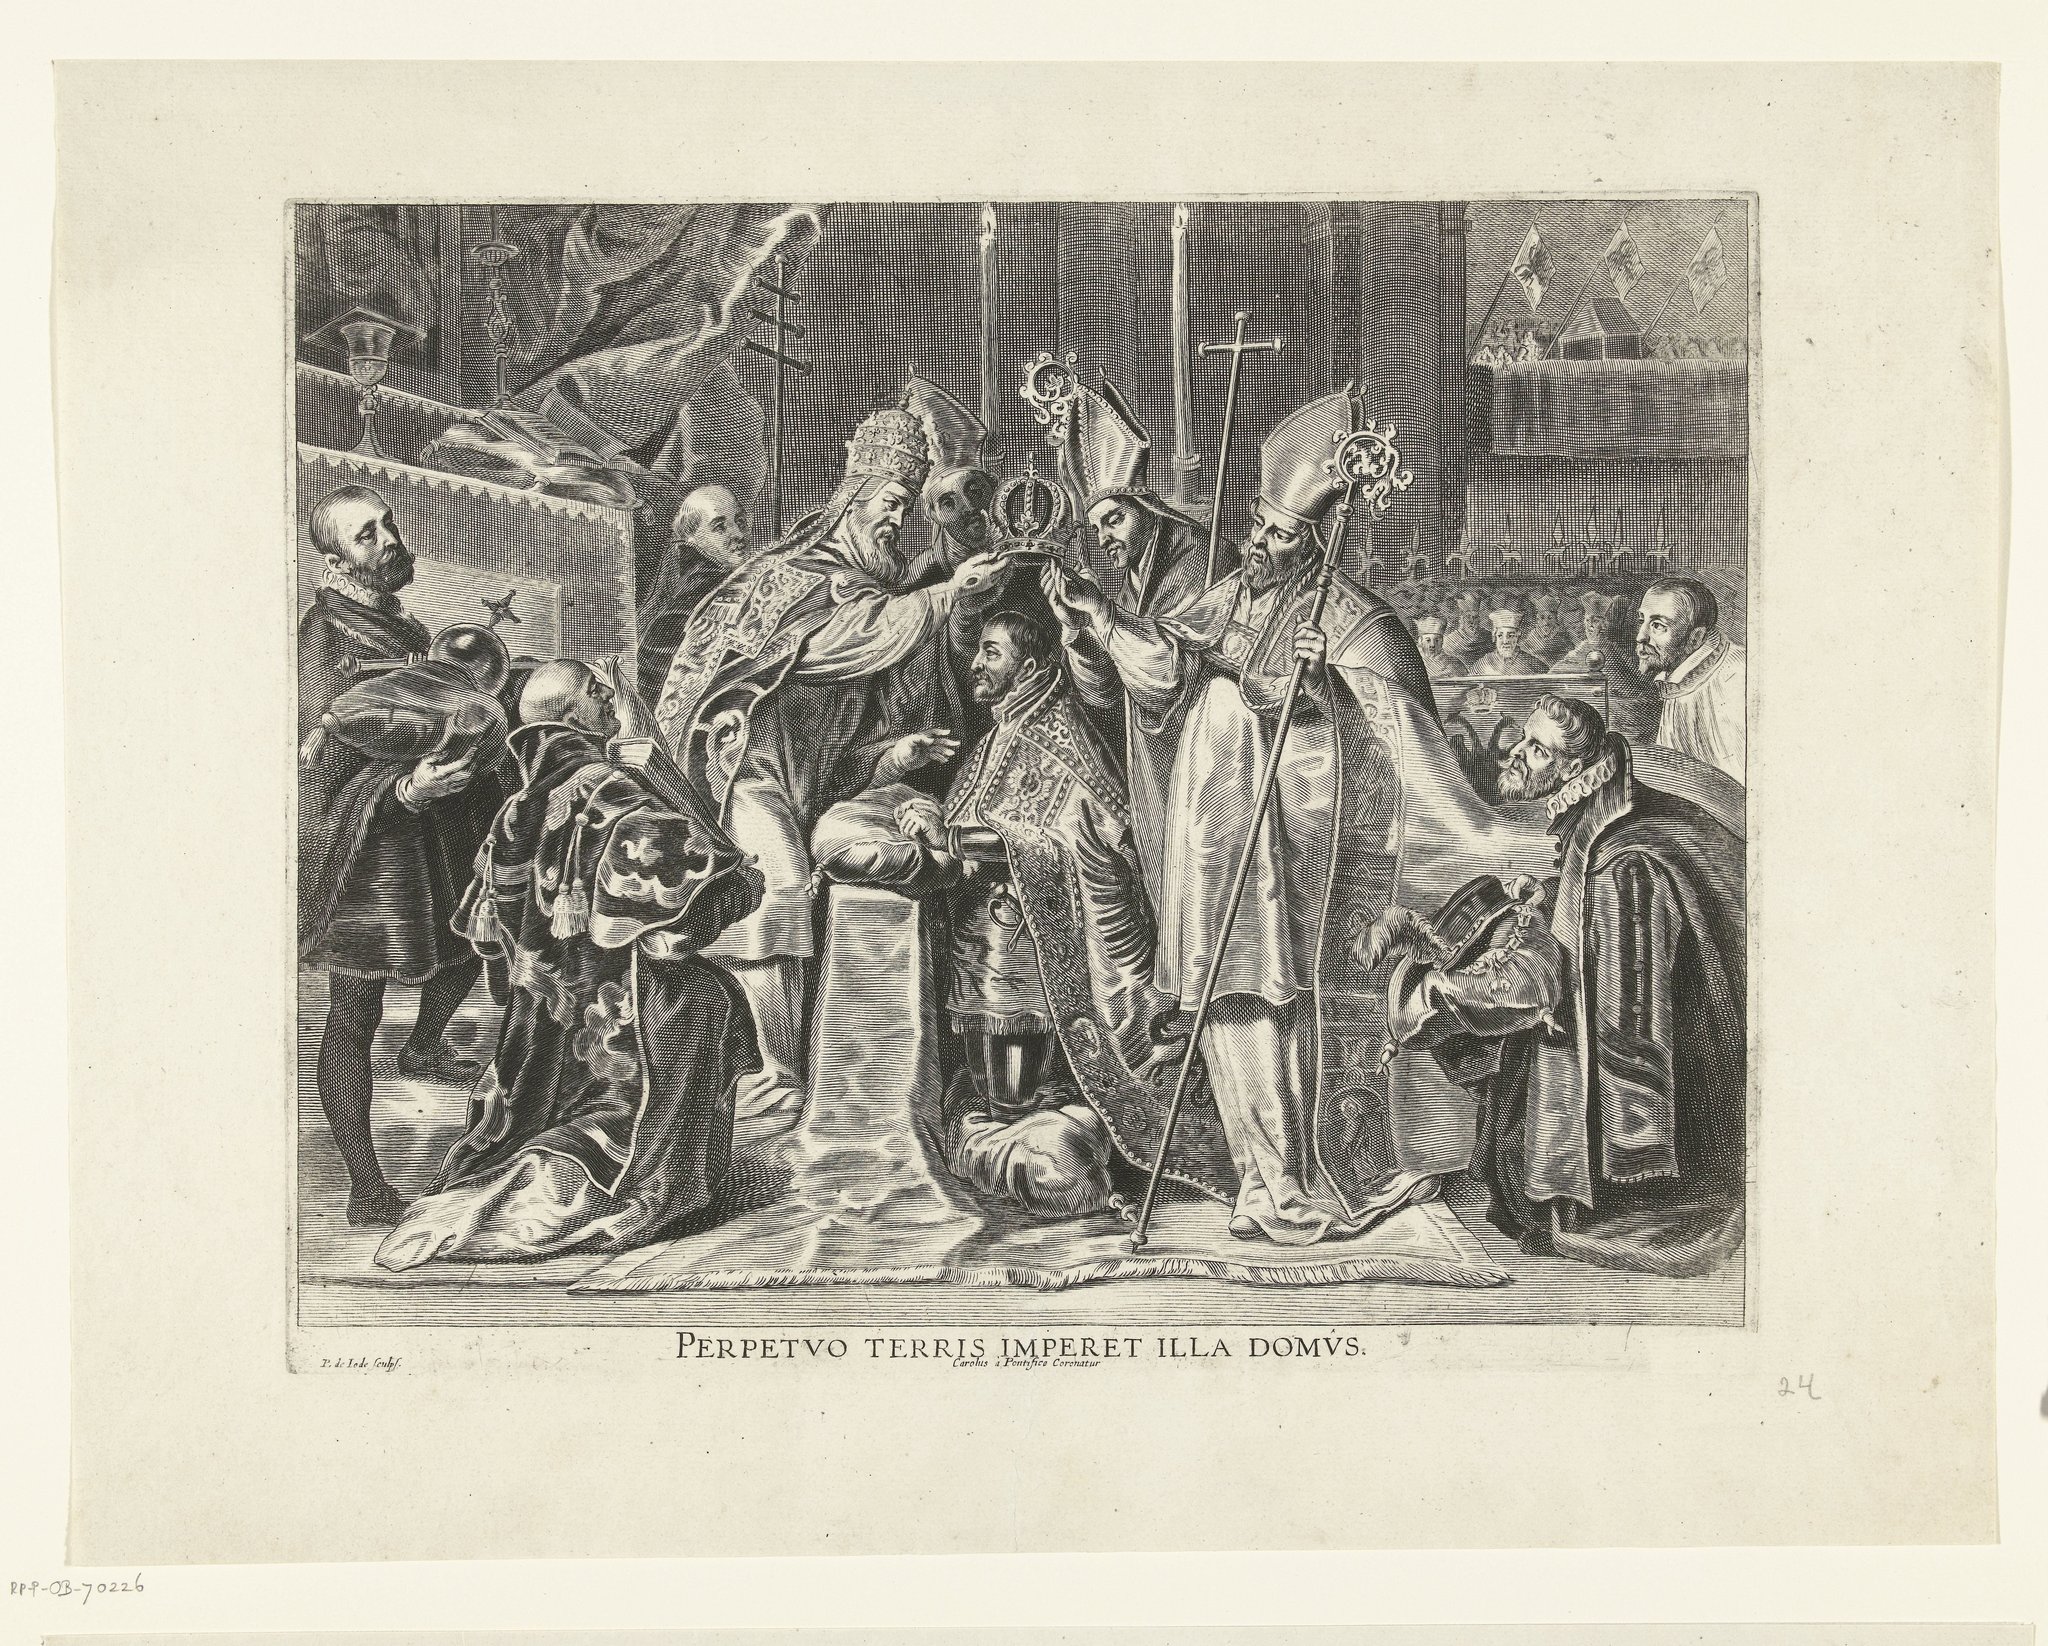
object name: print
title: Karel V tot keizer gekroond door de paus; intocht van Ferdinand te Gent in 1635 (nr. 24)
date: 1635-1636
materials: paper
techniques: engraving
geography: southern netherlands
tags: ghent, charles v (holy roman emperor and king of spain), rome, brussels, landvoogd der zuidelijke nederlanden ferdinand van oostenrijk, triumphal arch, during the coronation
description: Karel V tot keizer gekroond door paus Clemens VII te Bologna, 24 februari 1530. Voorstelling op een zijwand van de doorgang van de triomfpoort Arcus Caroli op de Vrijdagmarkt. Blad nr. 24 in een geheel van 42 platen die de uitgave van de beschrijving van de intocht van de Kardinaal Infant Ferdinand van Oostenrijk te Gent op 28 januari 1635 als de nieuwe landvoogd voor de Spaanse Nederlanden illustreren.